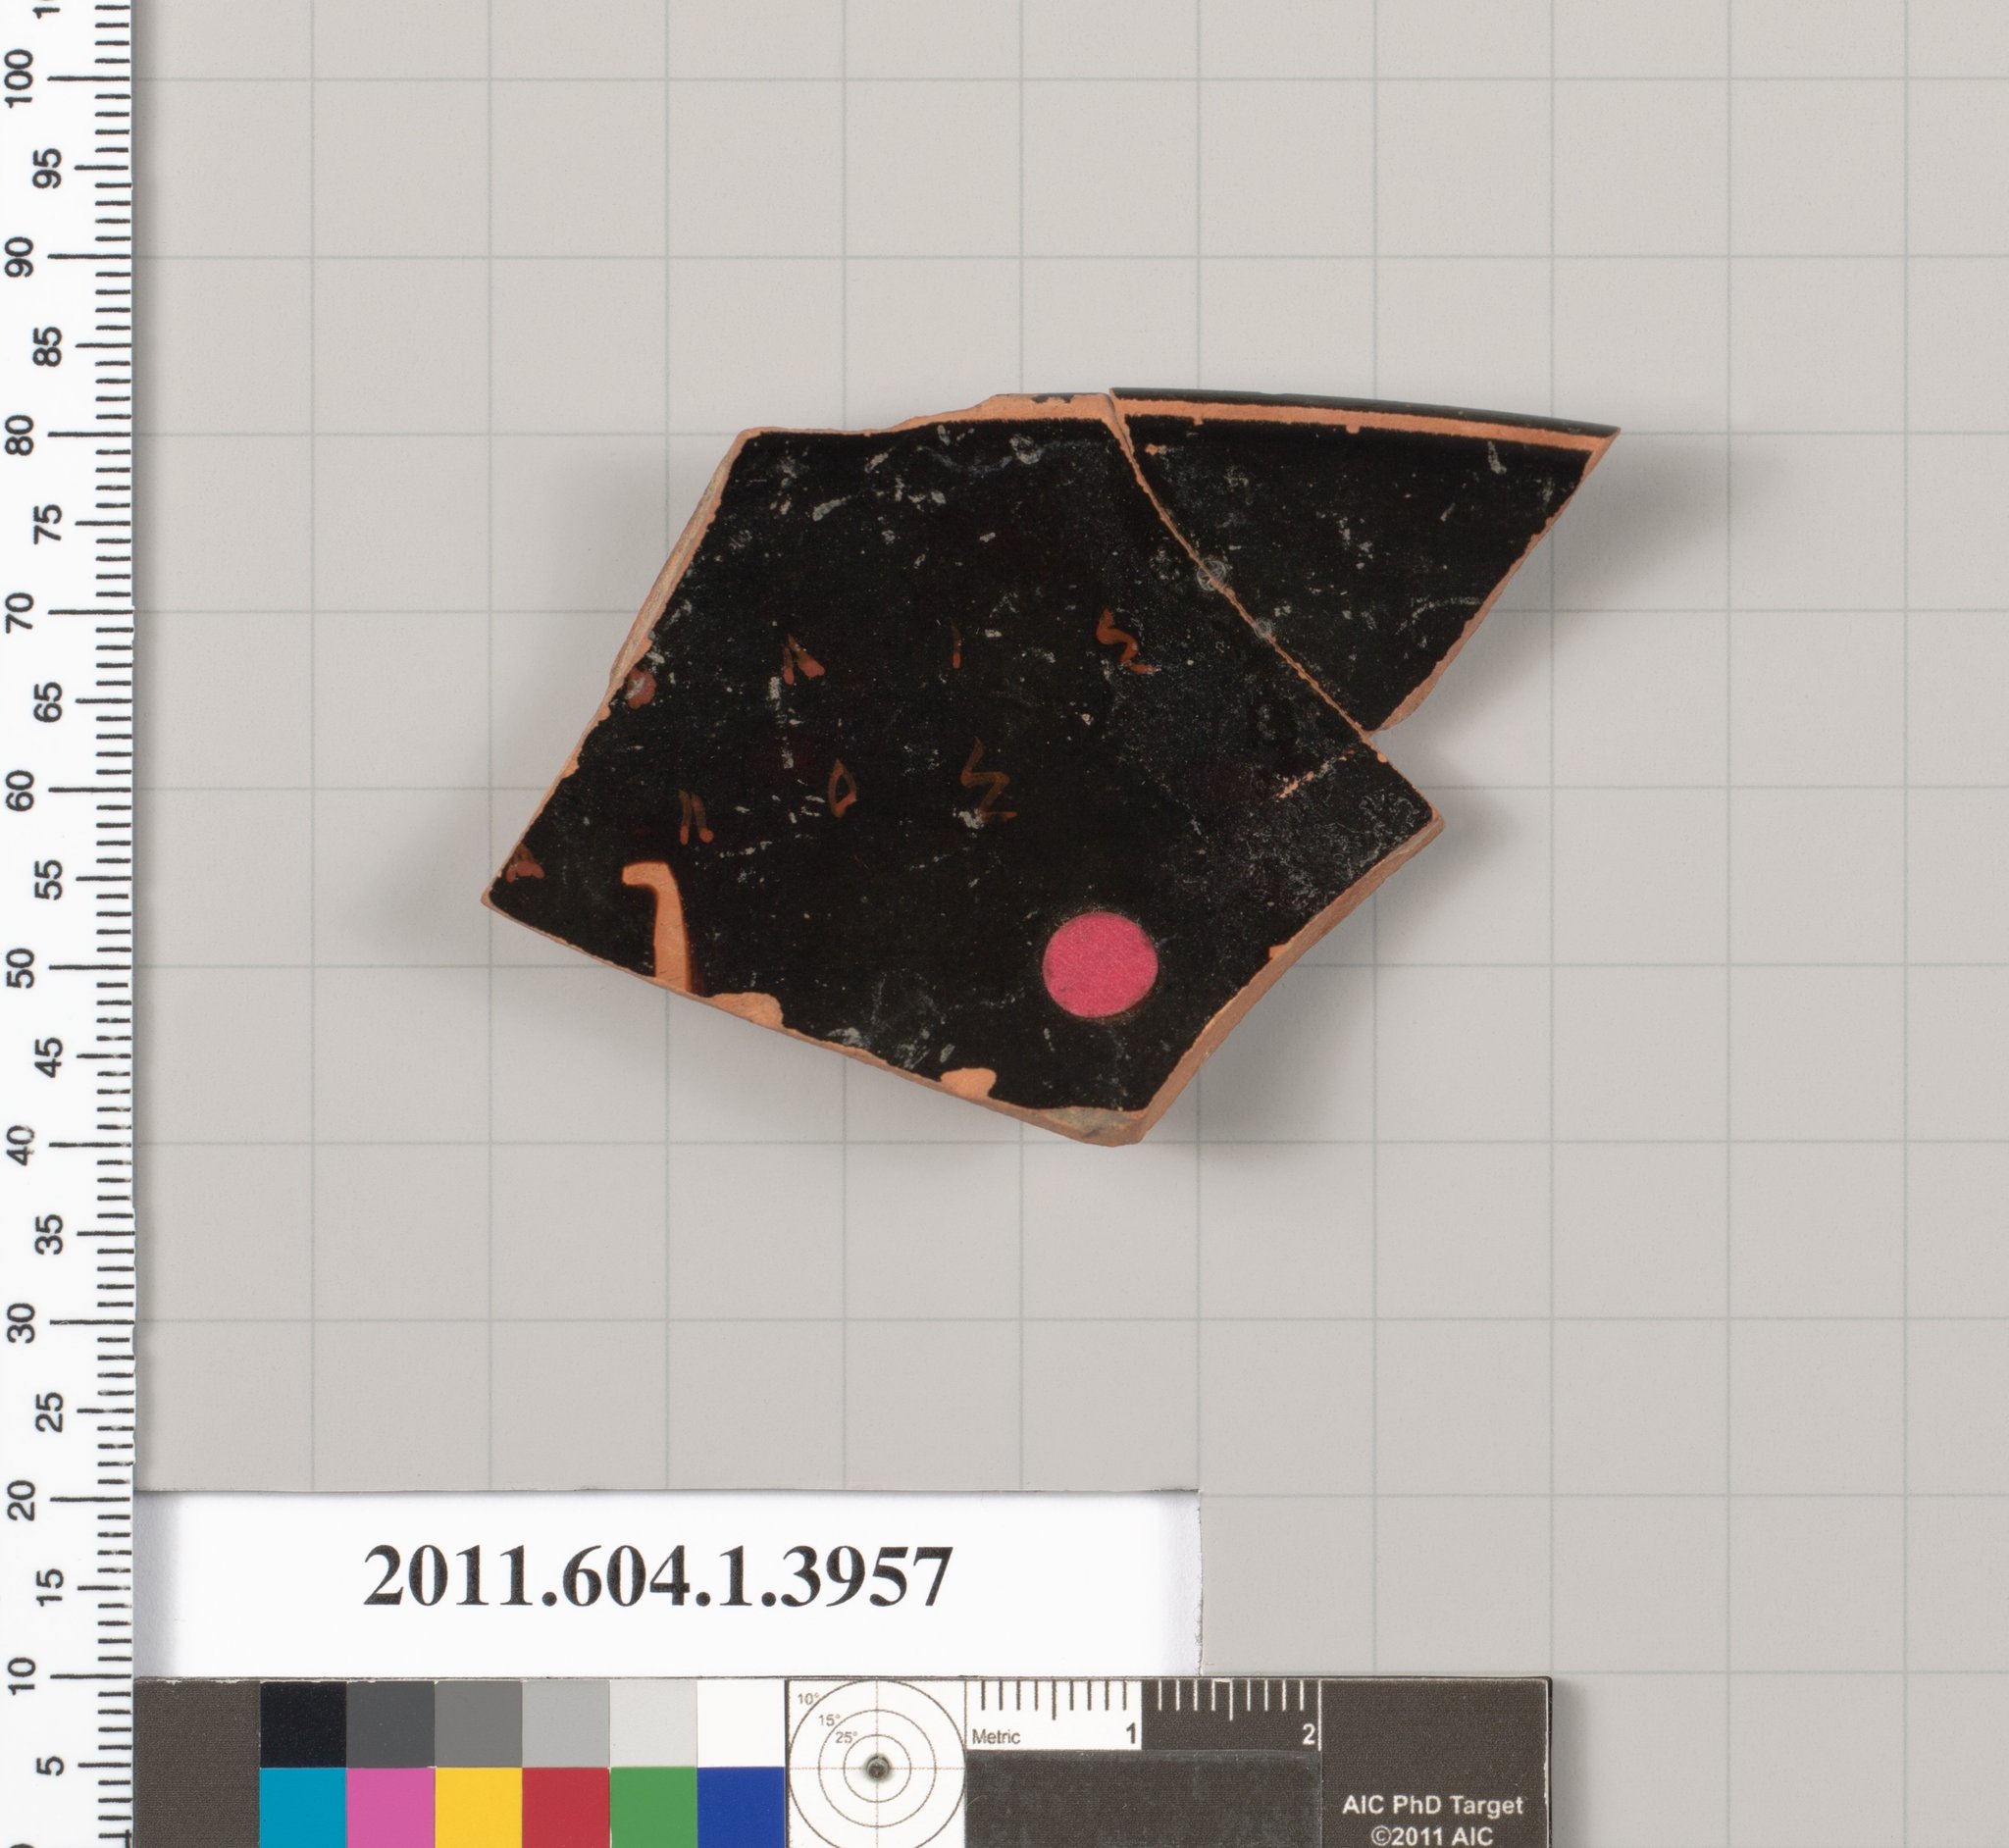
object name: kylix fragment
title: Terracotta rim fragment of a kylix (drinking cup)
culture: greek, attic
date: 475-451 BCE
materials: terracotta